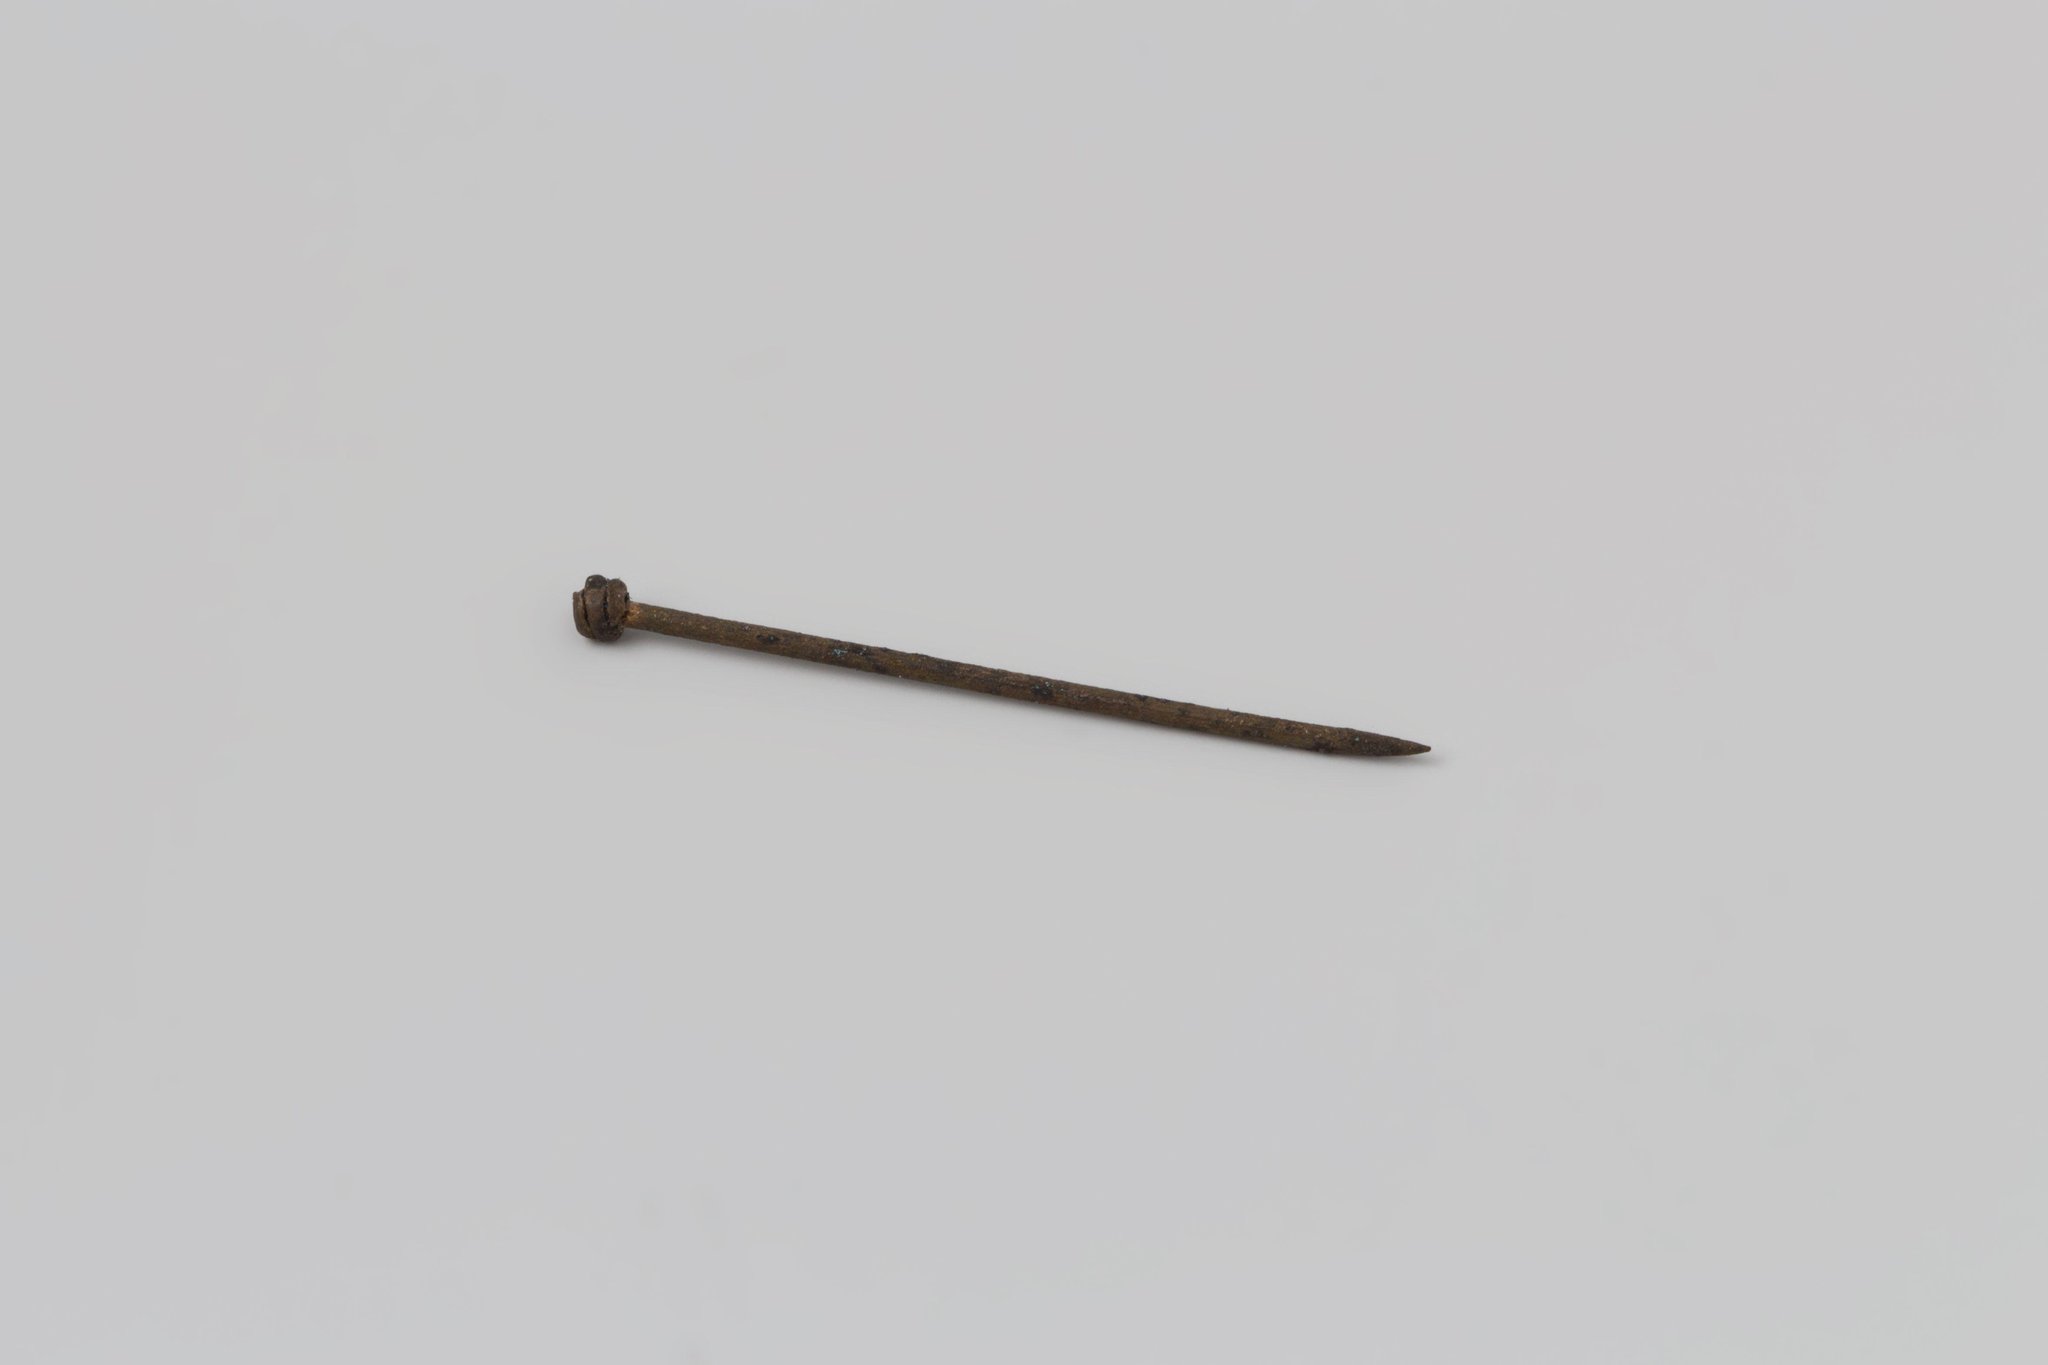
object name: pin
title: Speld uit het wrak van de Oost-Indiëvaarder 't Vliegend Hart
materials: copper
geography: middelburg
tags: 't vliegend hart (schip), verenigde oostindische compagnie